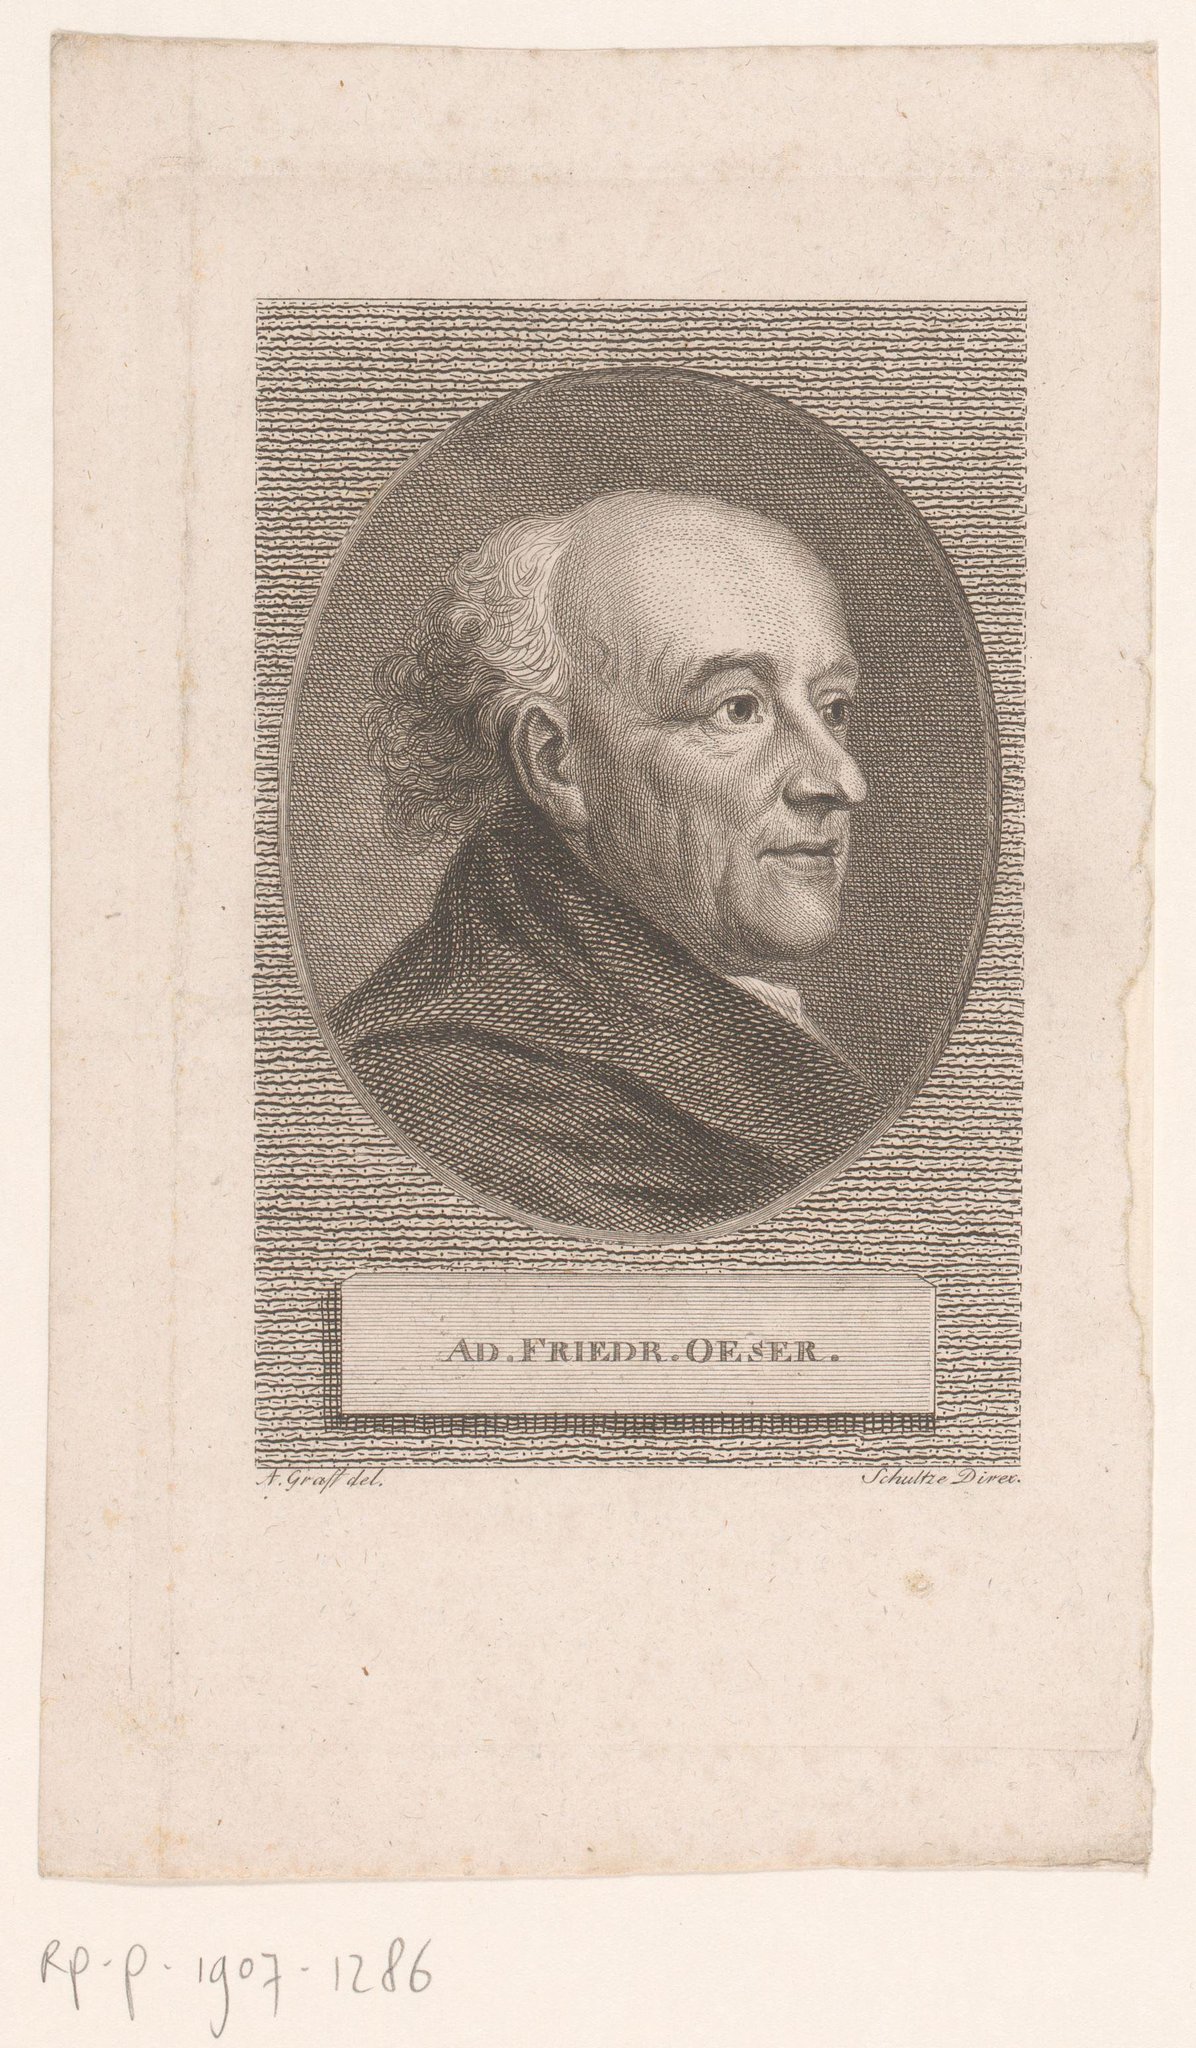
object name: print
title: Portret van Adam Friedrich Oeser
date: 1759-1819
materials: paper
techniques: etching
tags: painter, print maker, sculptor, adam friedrich oeser, historical persons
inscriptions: collector's mark: Lugt 2228